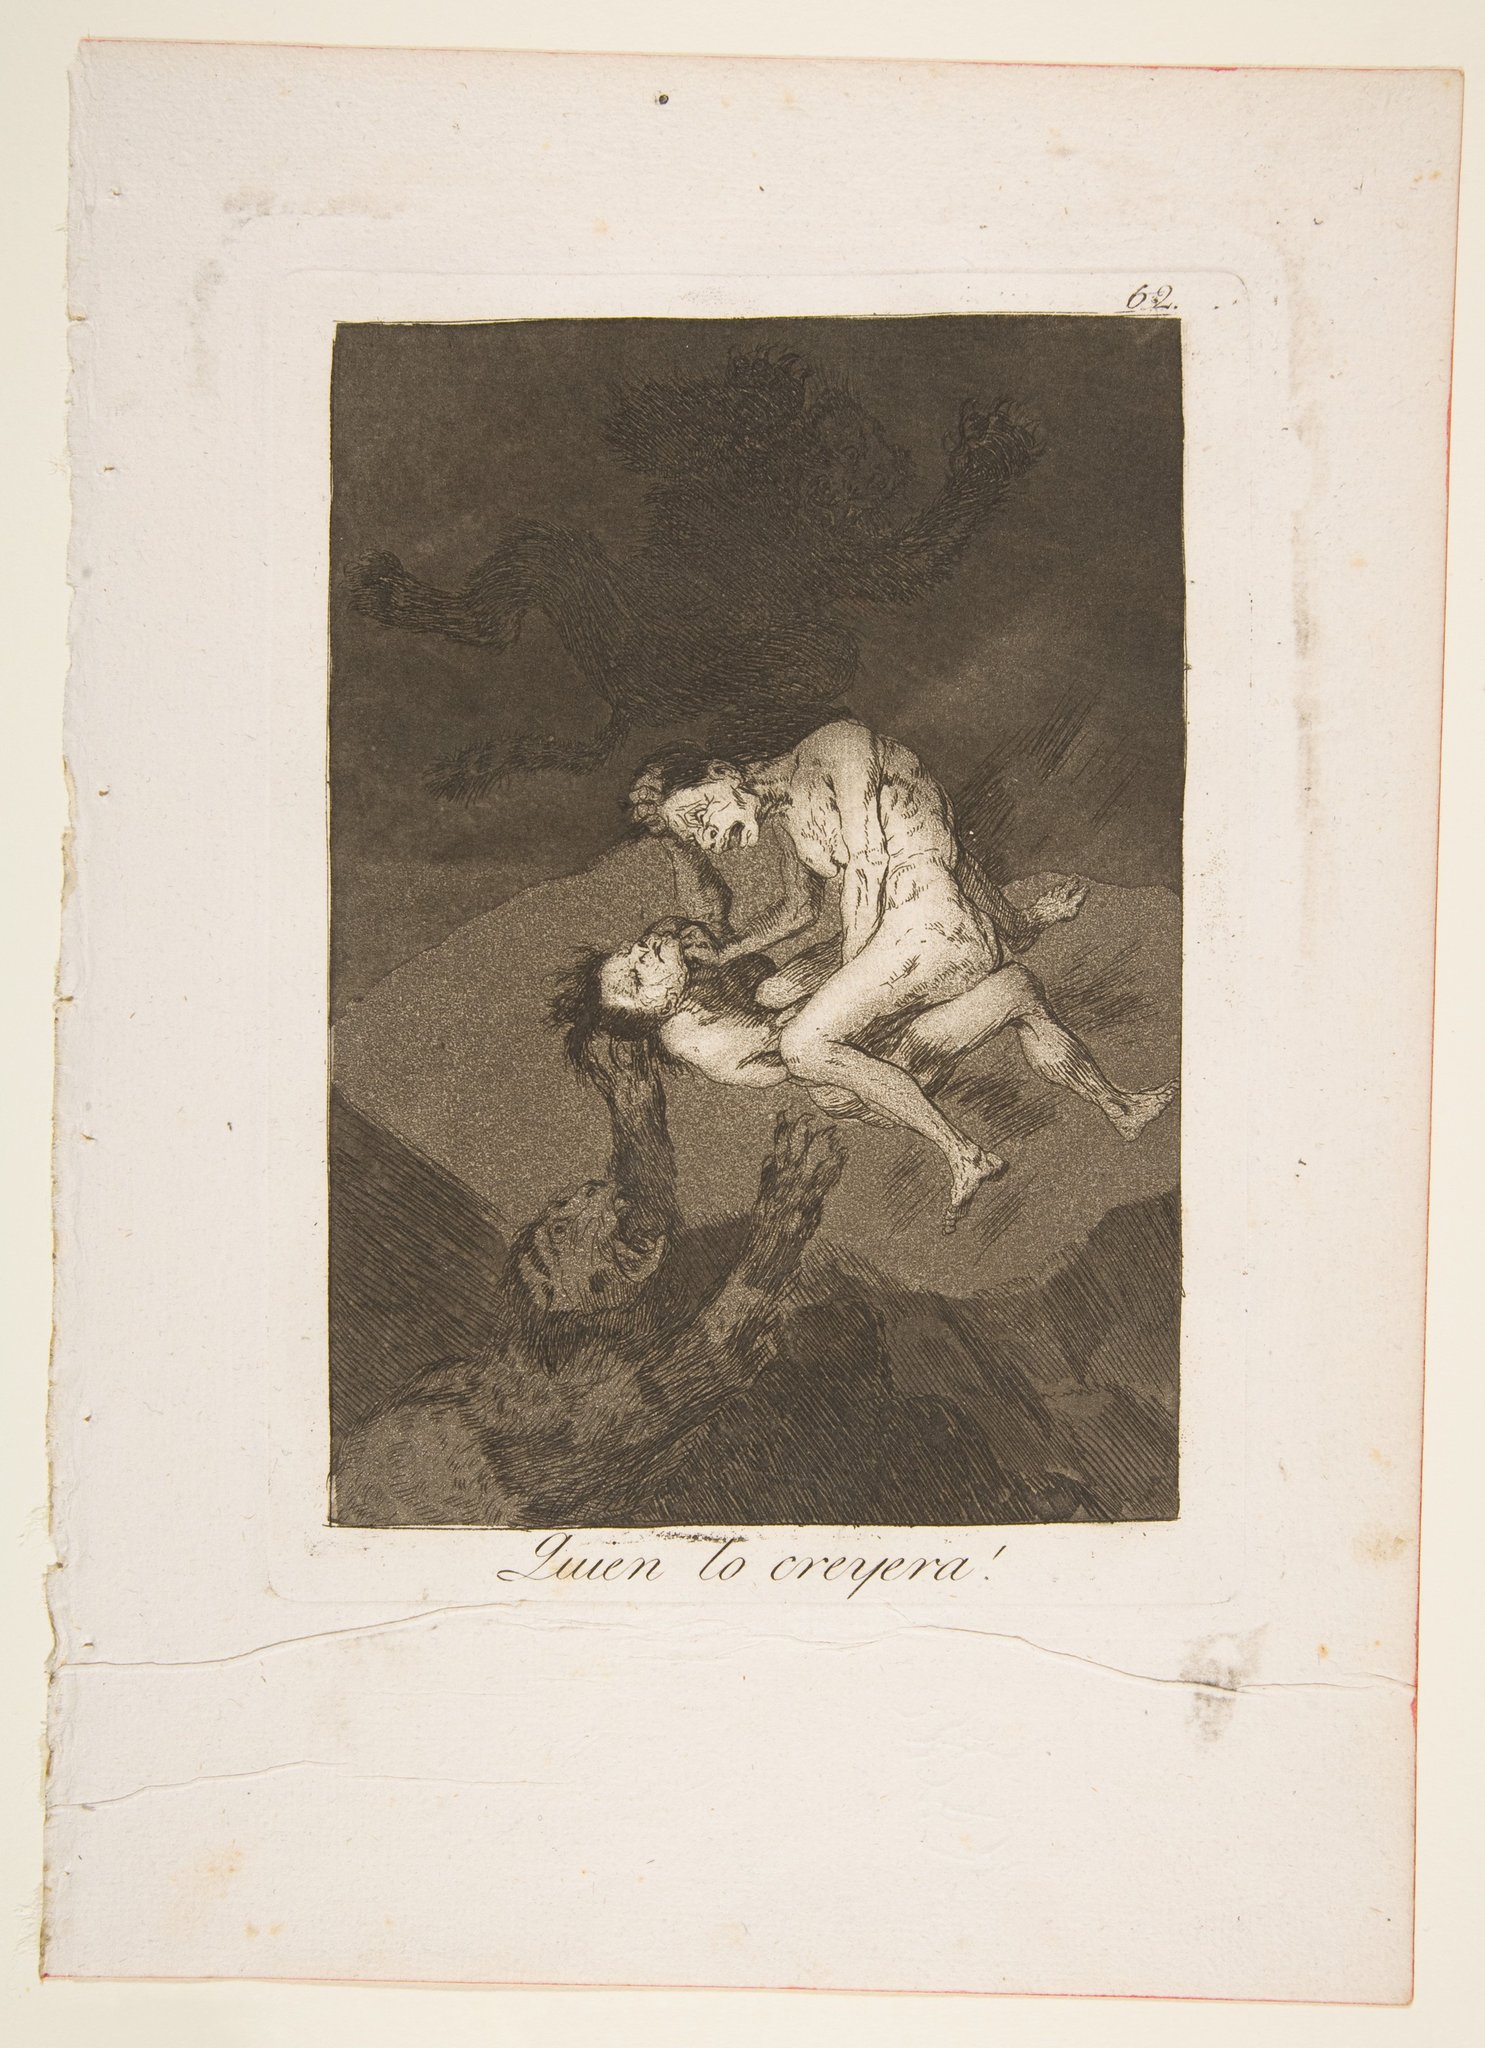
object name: print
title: Plate 62 from "Los Caprichos": Who would have thought it? (Quien lo creyera!)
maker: goya (francisco de goya y lucientes)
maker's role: artist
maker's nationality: spanish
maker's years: 1746-1828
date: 1799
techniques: aquatint, engraving, burnishing, etching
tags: male nudes,lions